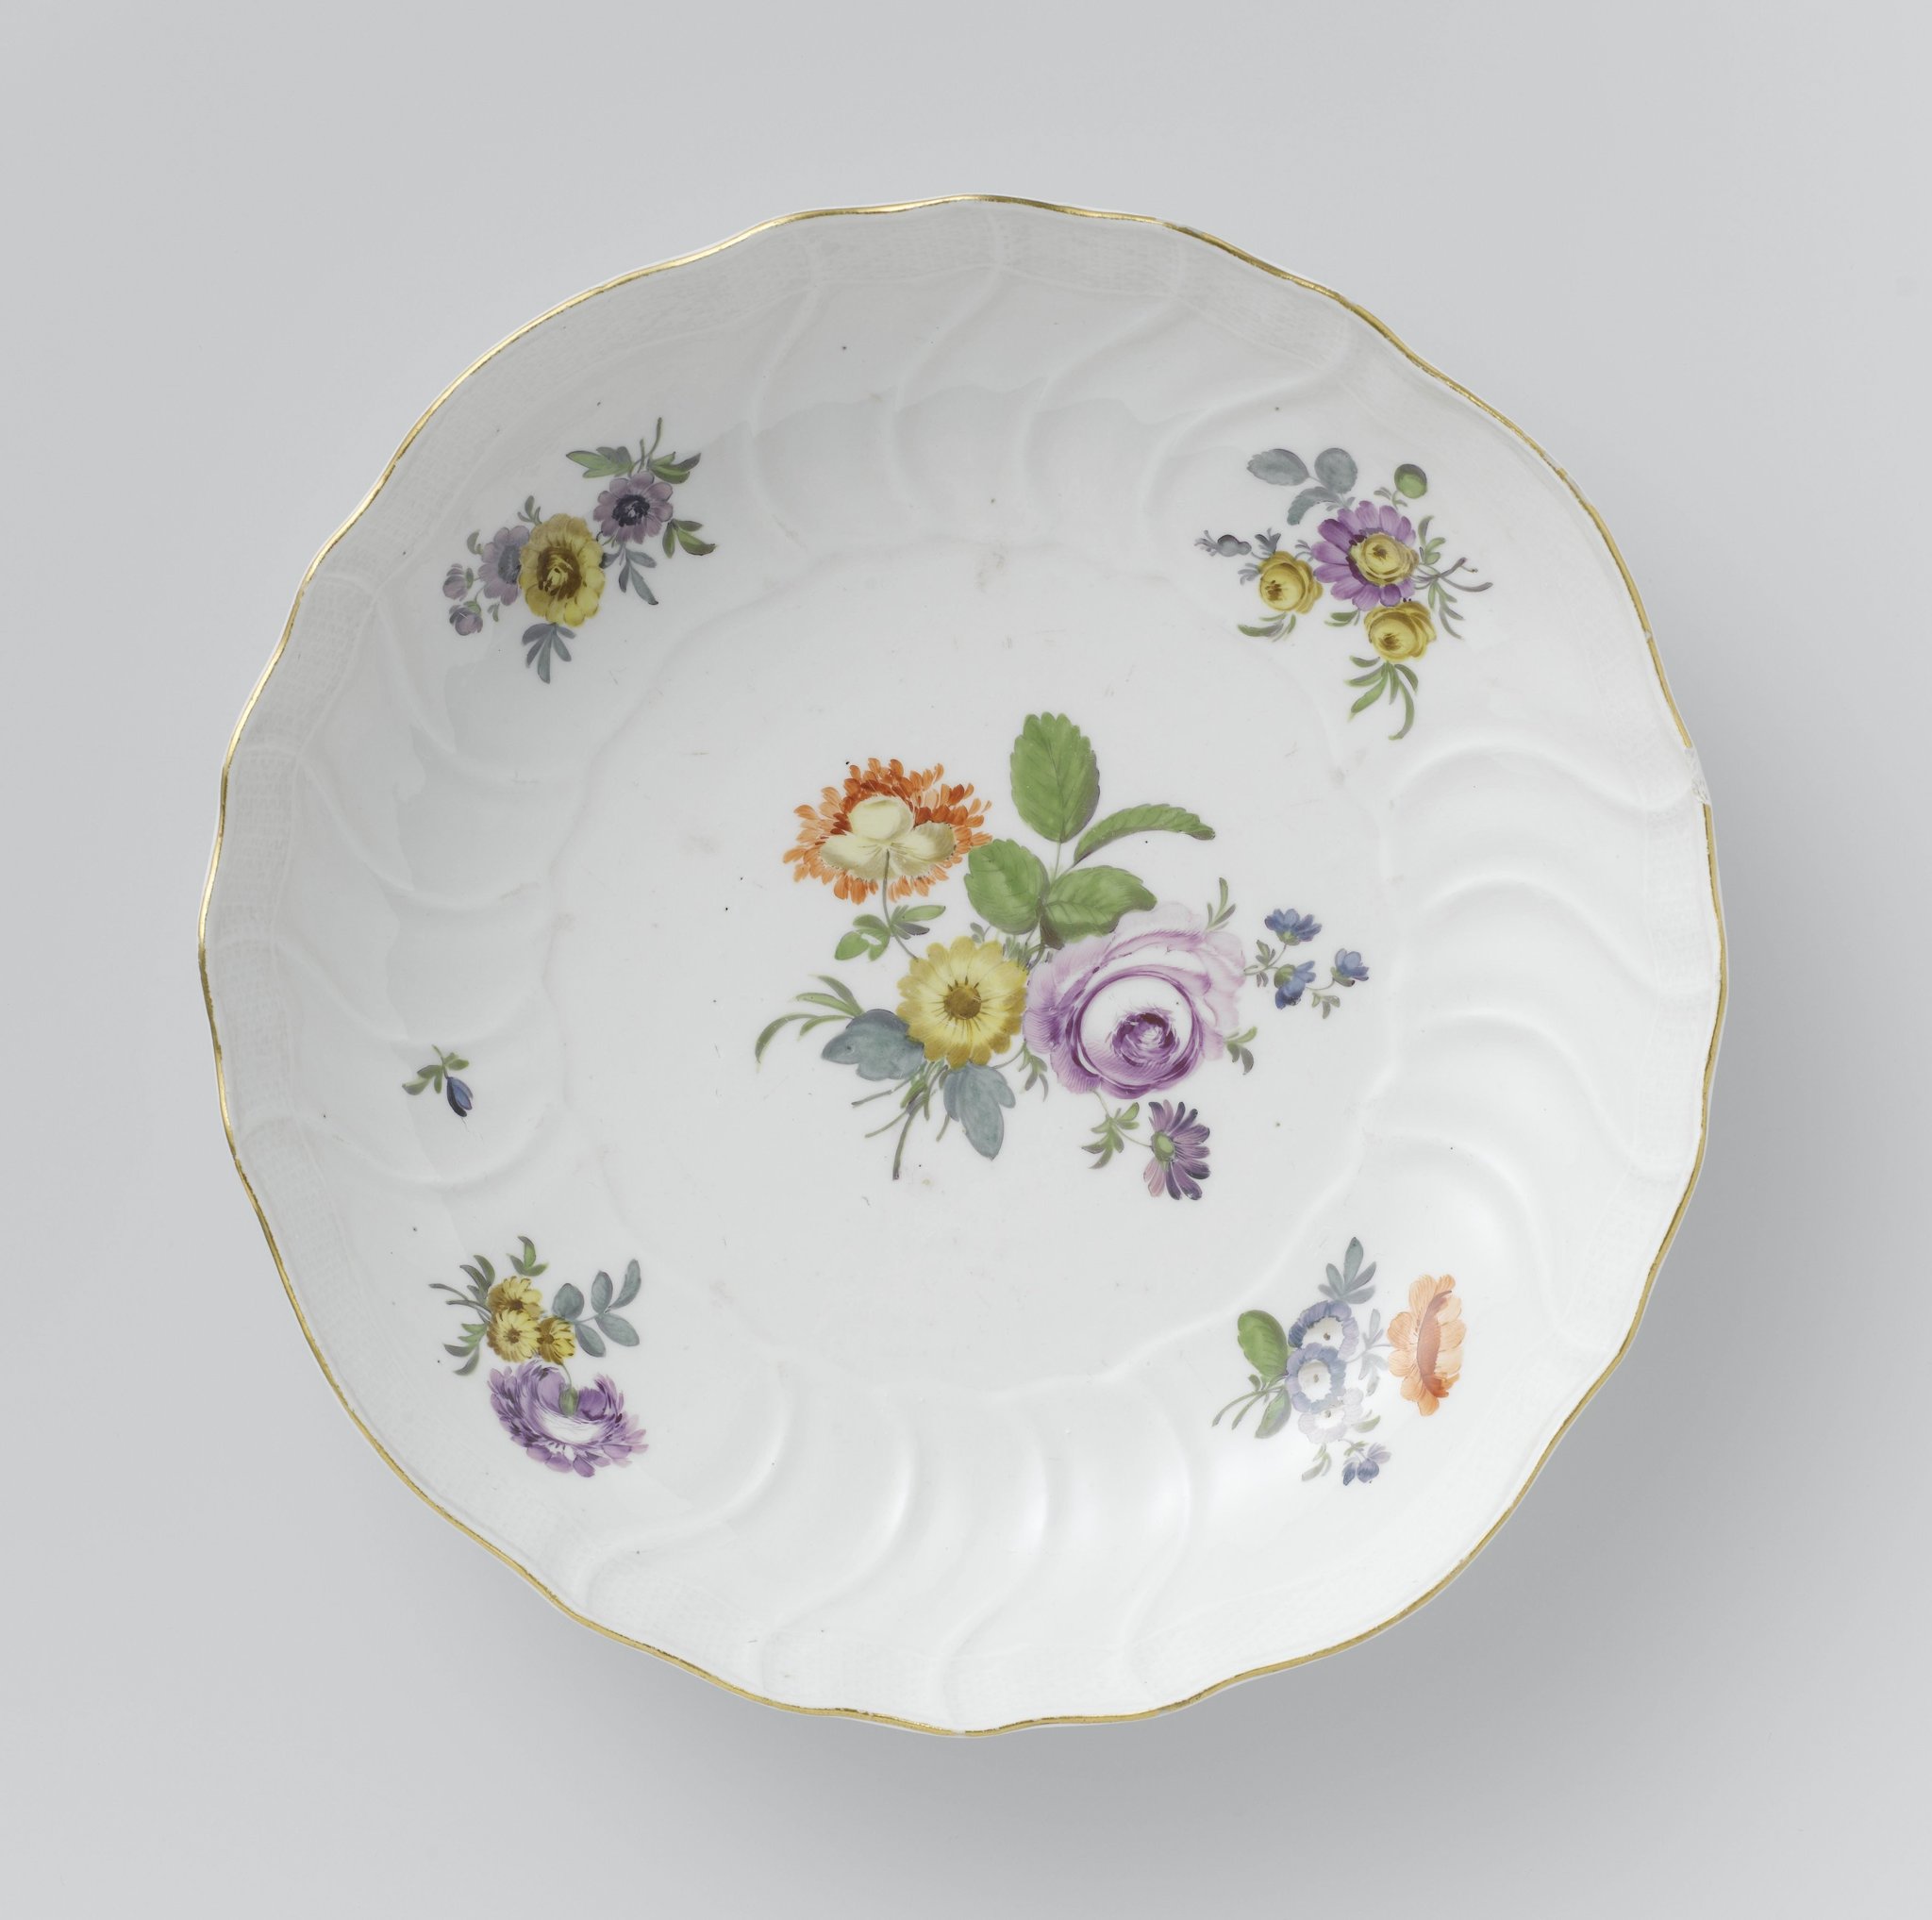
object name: platter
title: Schotel, veelkleurig beschilderd met Deutsche Blumen, insekten en vruchten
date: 1750-1760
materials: porcelain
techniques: painted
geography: meissen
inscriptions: factory mark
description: Ronde schotel van beschilderd porselein. De schotel is beschilderd met Deutsche Blumen, insekten en vruchten. De rand is in reliëf versierd met het Neuozier-patroon. De schotel is gemerkt en hoort bij een servies (BK-17474-1 t/m BK-17474-253).